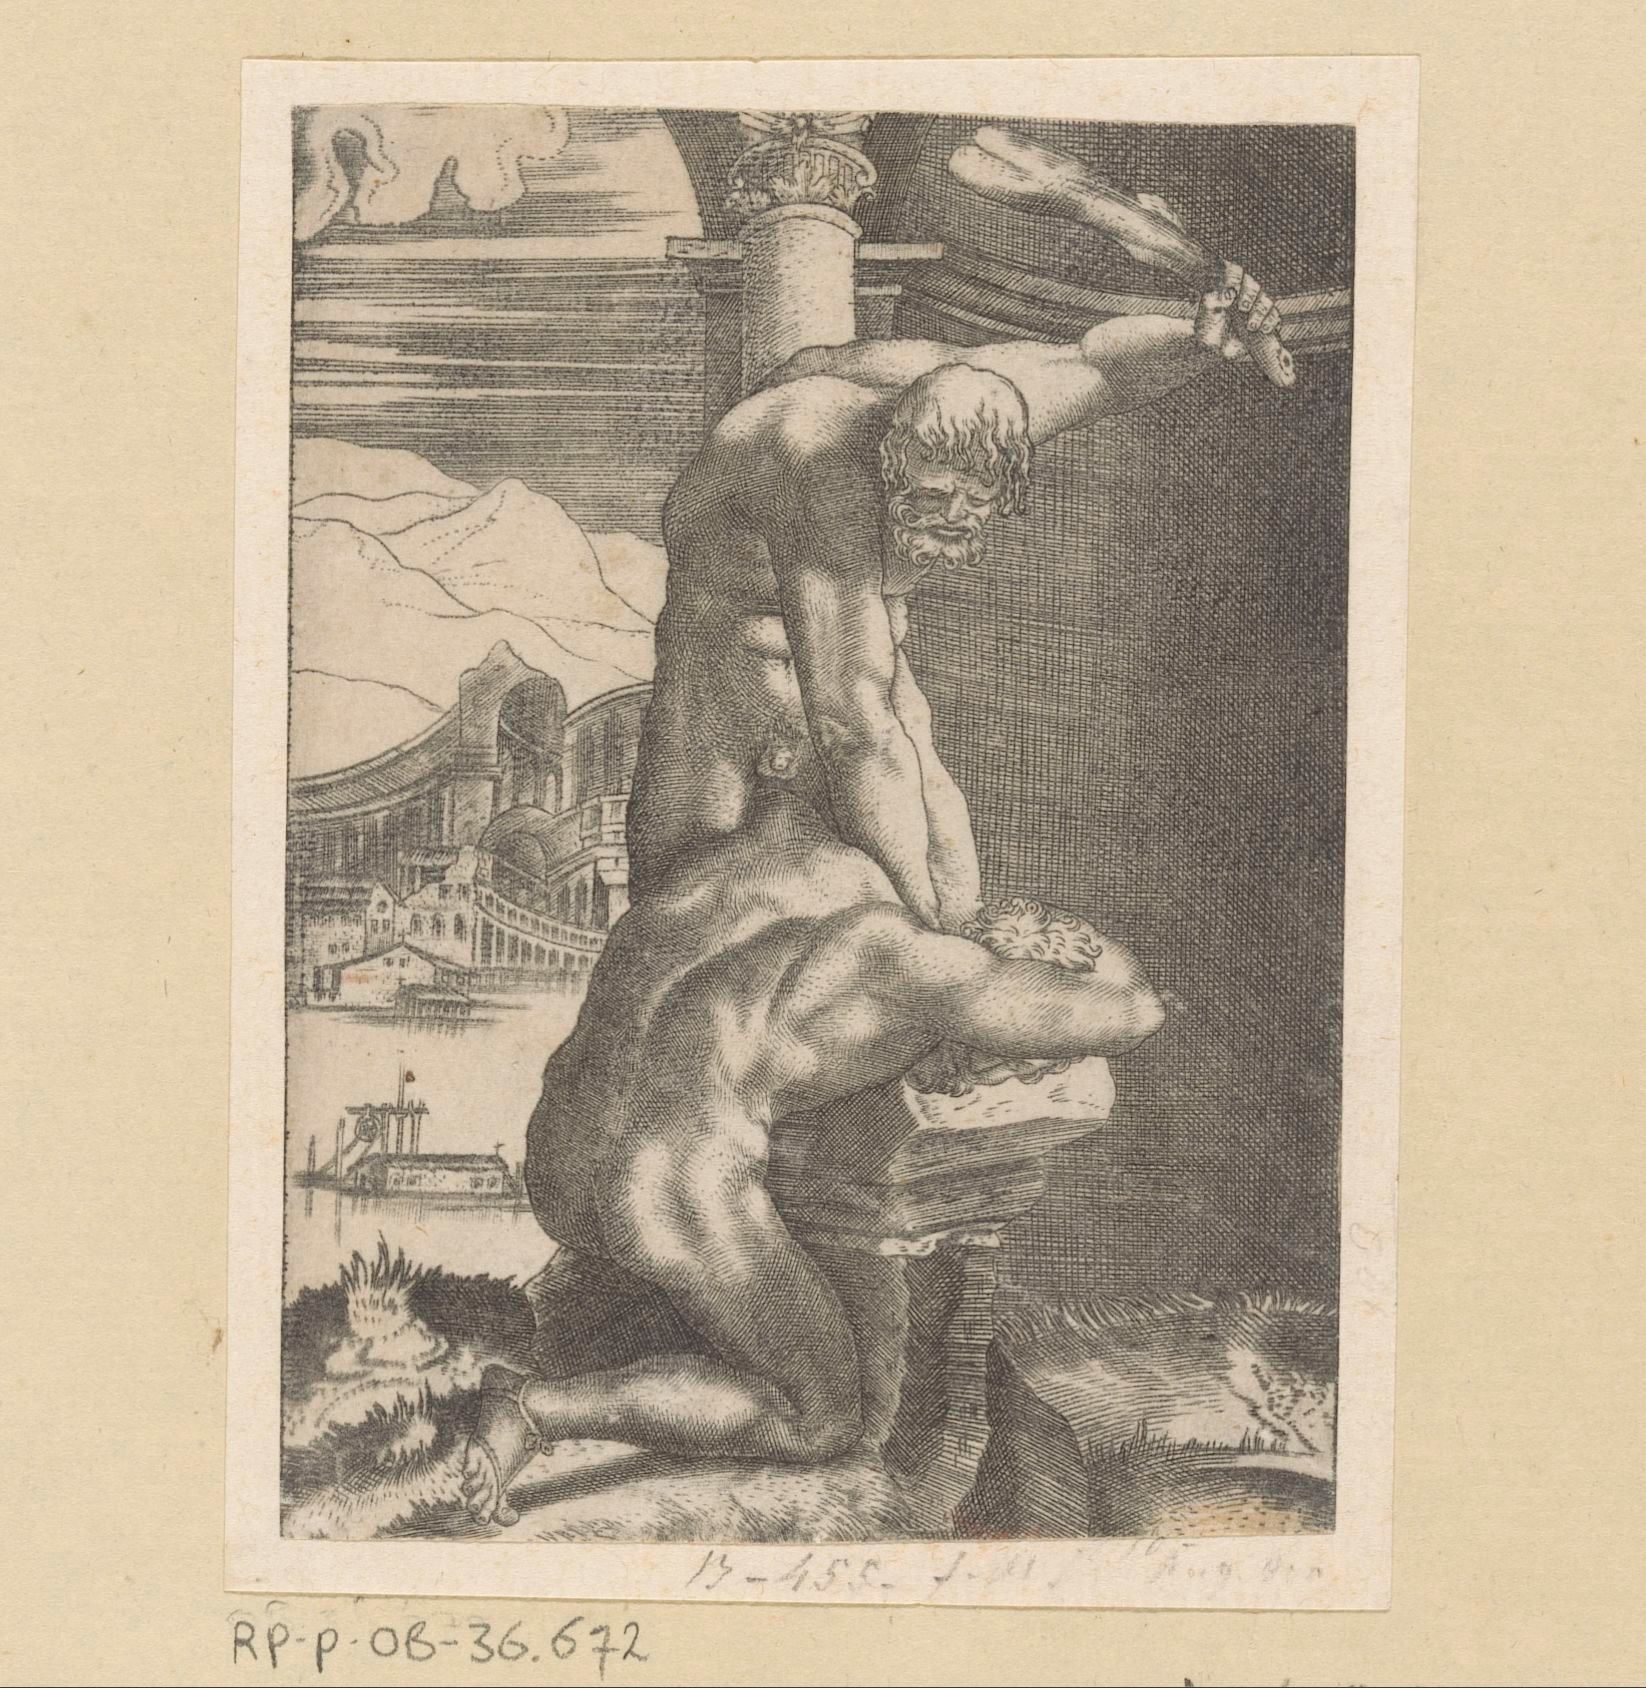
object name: print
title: Kaïn slaat Abel dood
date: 1500-1536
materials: paper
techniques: engraving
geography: italy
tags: the killing of abel: cain slays him with a stone, a club or a jaw-bone, alternatively with a spade or another tool as weapon, weapons for striking a blow, fighting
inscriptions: collector's mark: Lugt 2228, collector's mark: Lugt 12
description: Kaïn staat op het punt om Abel dood te slaan met een wapen, mogelijk het kaakbeen van een ezel. Links op de achtergrond een landschap met bebouwing, water en bergen.